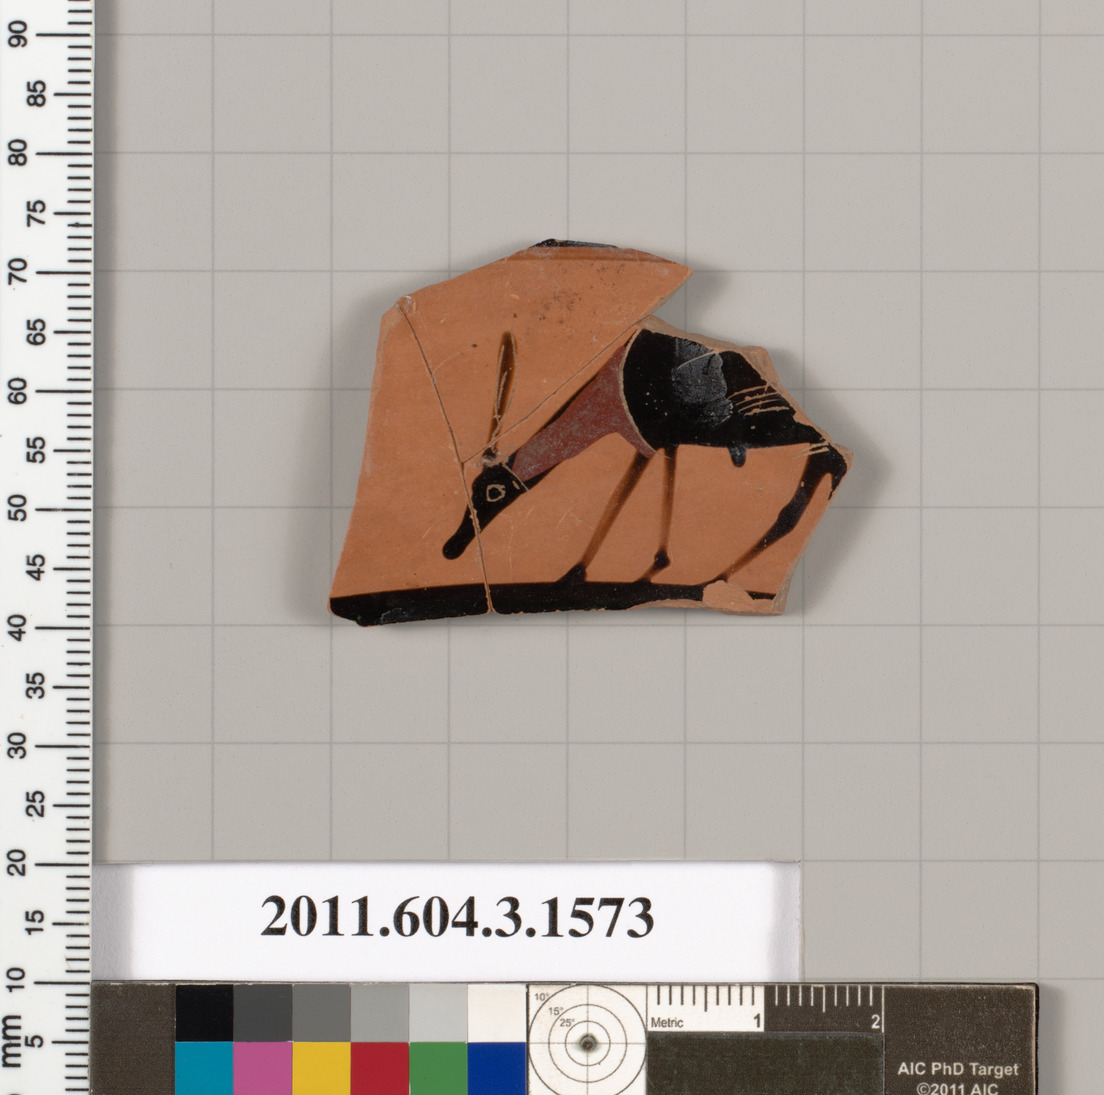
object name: kylix fragment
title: Terracotta fragment of a kylix: Band cup (drinking cup)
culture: greek, attic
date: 550-526 BCE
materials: terracotta